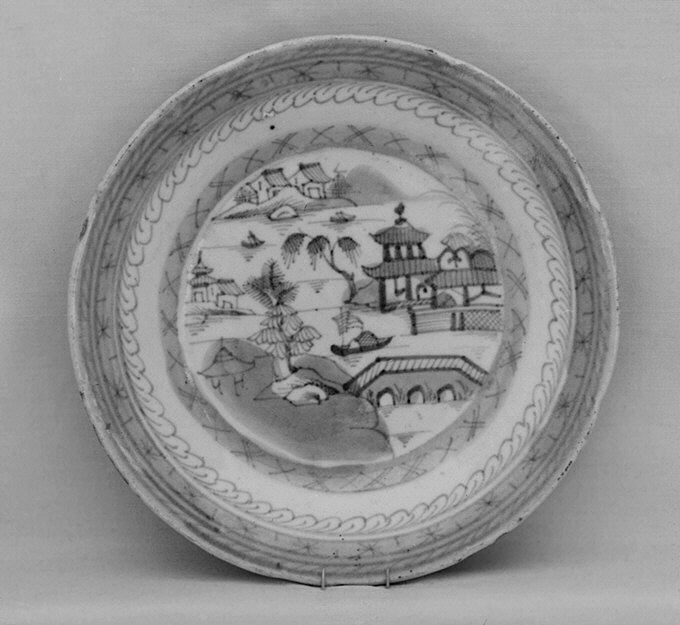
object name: plate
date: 1801-1833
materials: hard paste porcelain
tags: houses,trees,boats